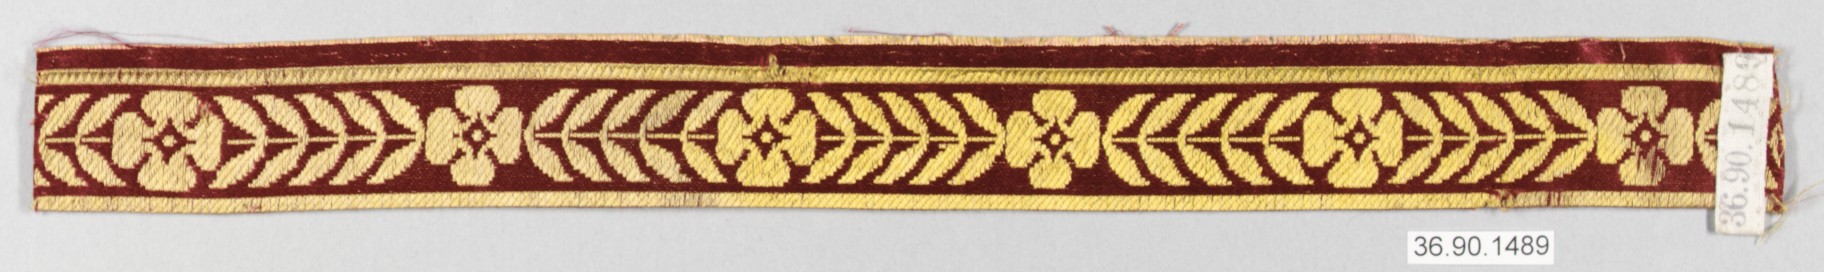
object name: ribbon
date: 1801-1900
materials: silk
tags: flowers